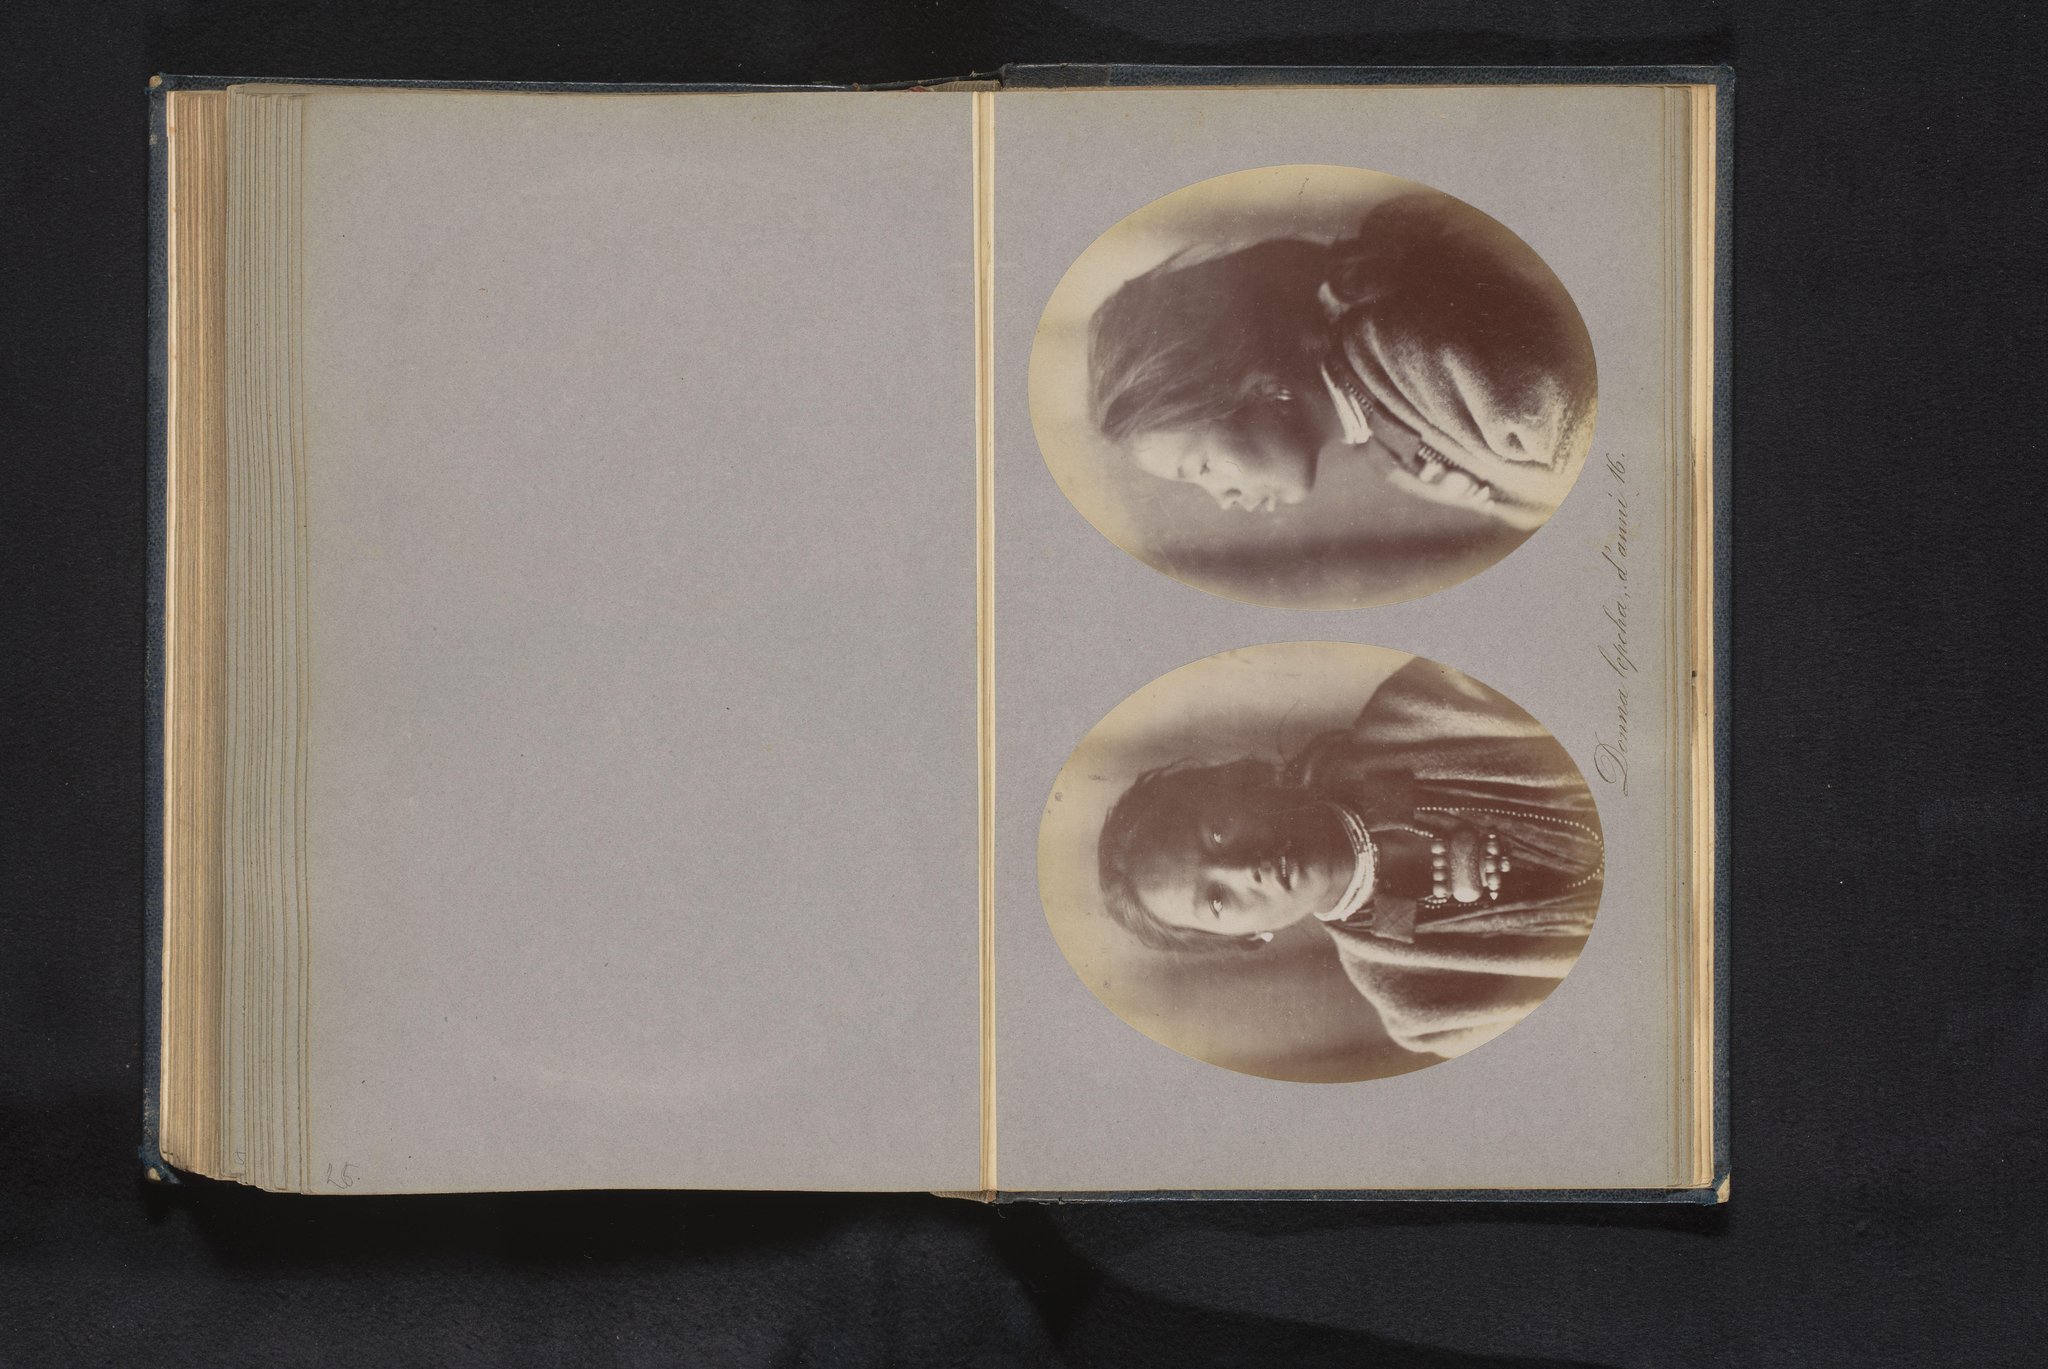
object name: page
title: Donna lepcha, d'anni 16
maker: paolo mantegazza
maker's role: antropoloog, professor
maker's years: 1831-1910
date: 1881-1886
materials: photographic support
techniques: albumen print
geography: india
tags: adolescent, young woman, maiden (+ sideview, profile), adolescent, young woman, maiden (+ front view)